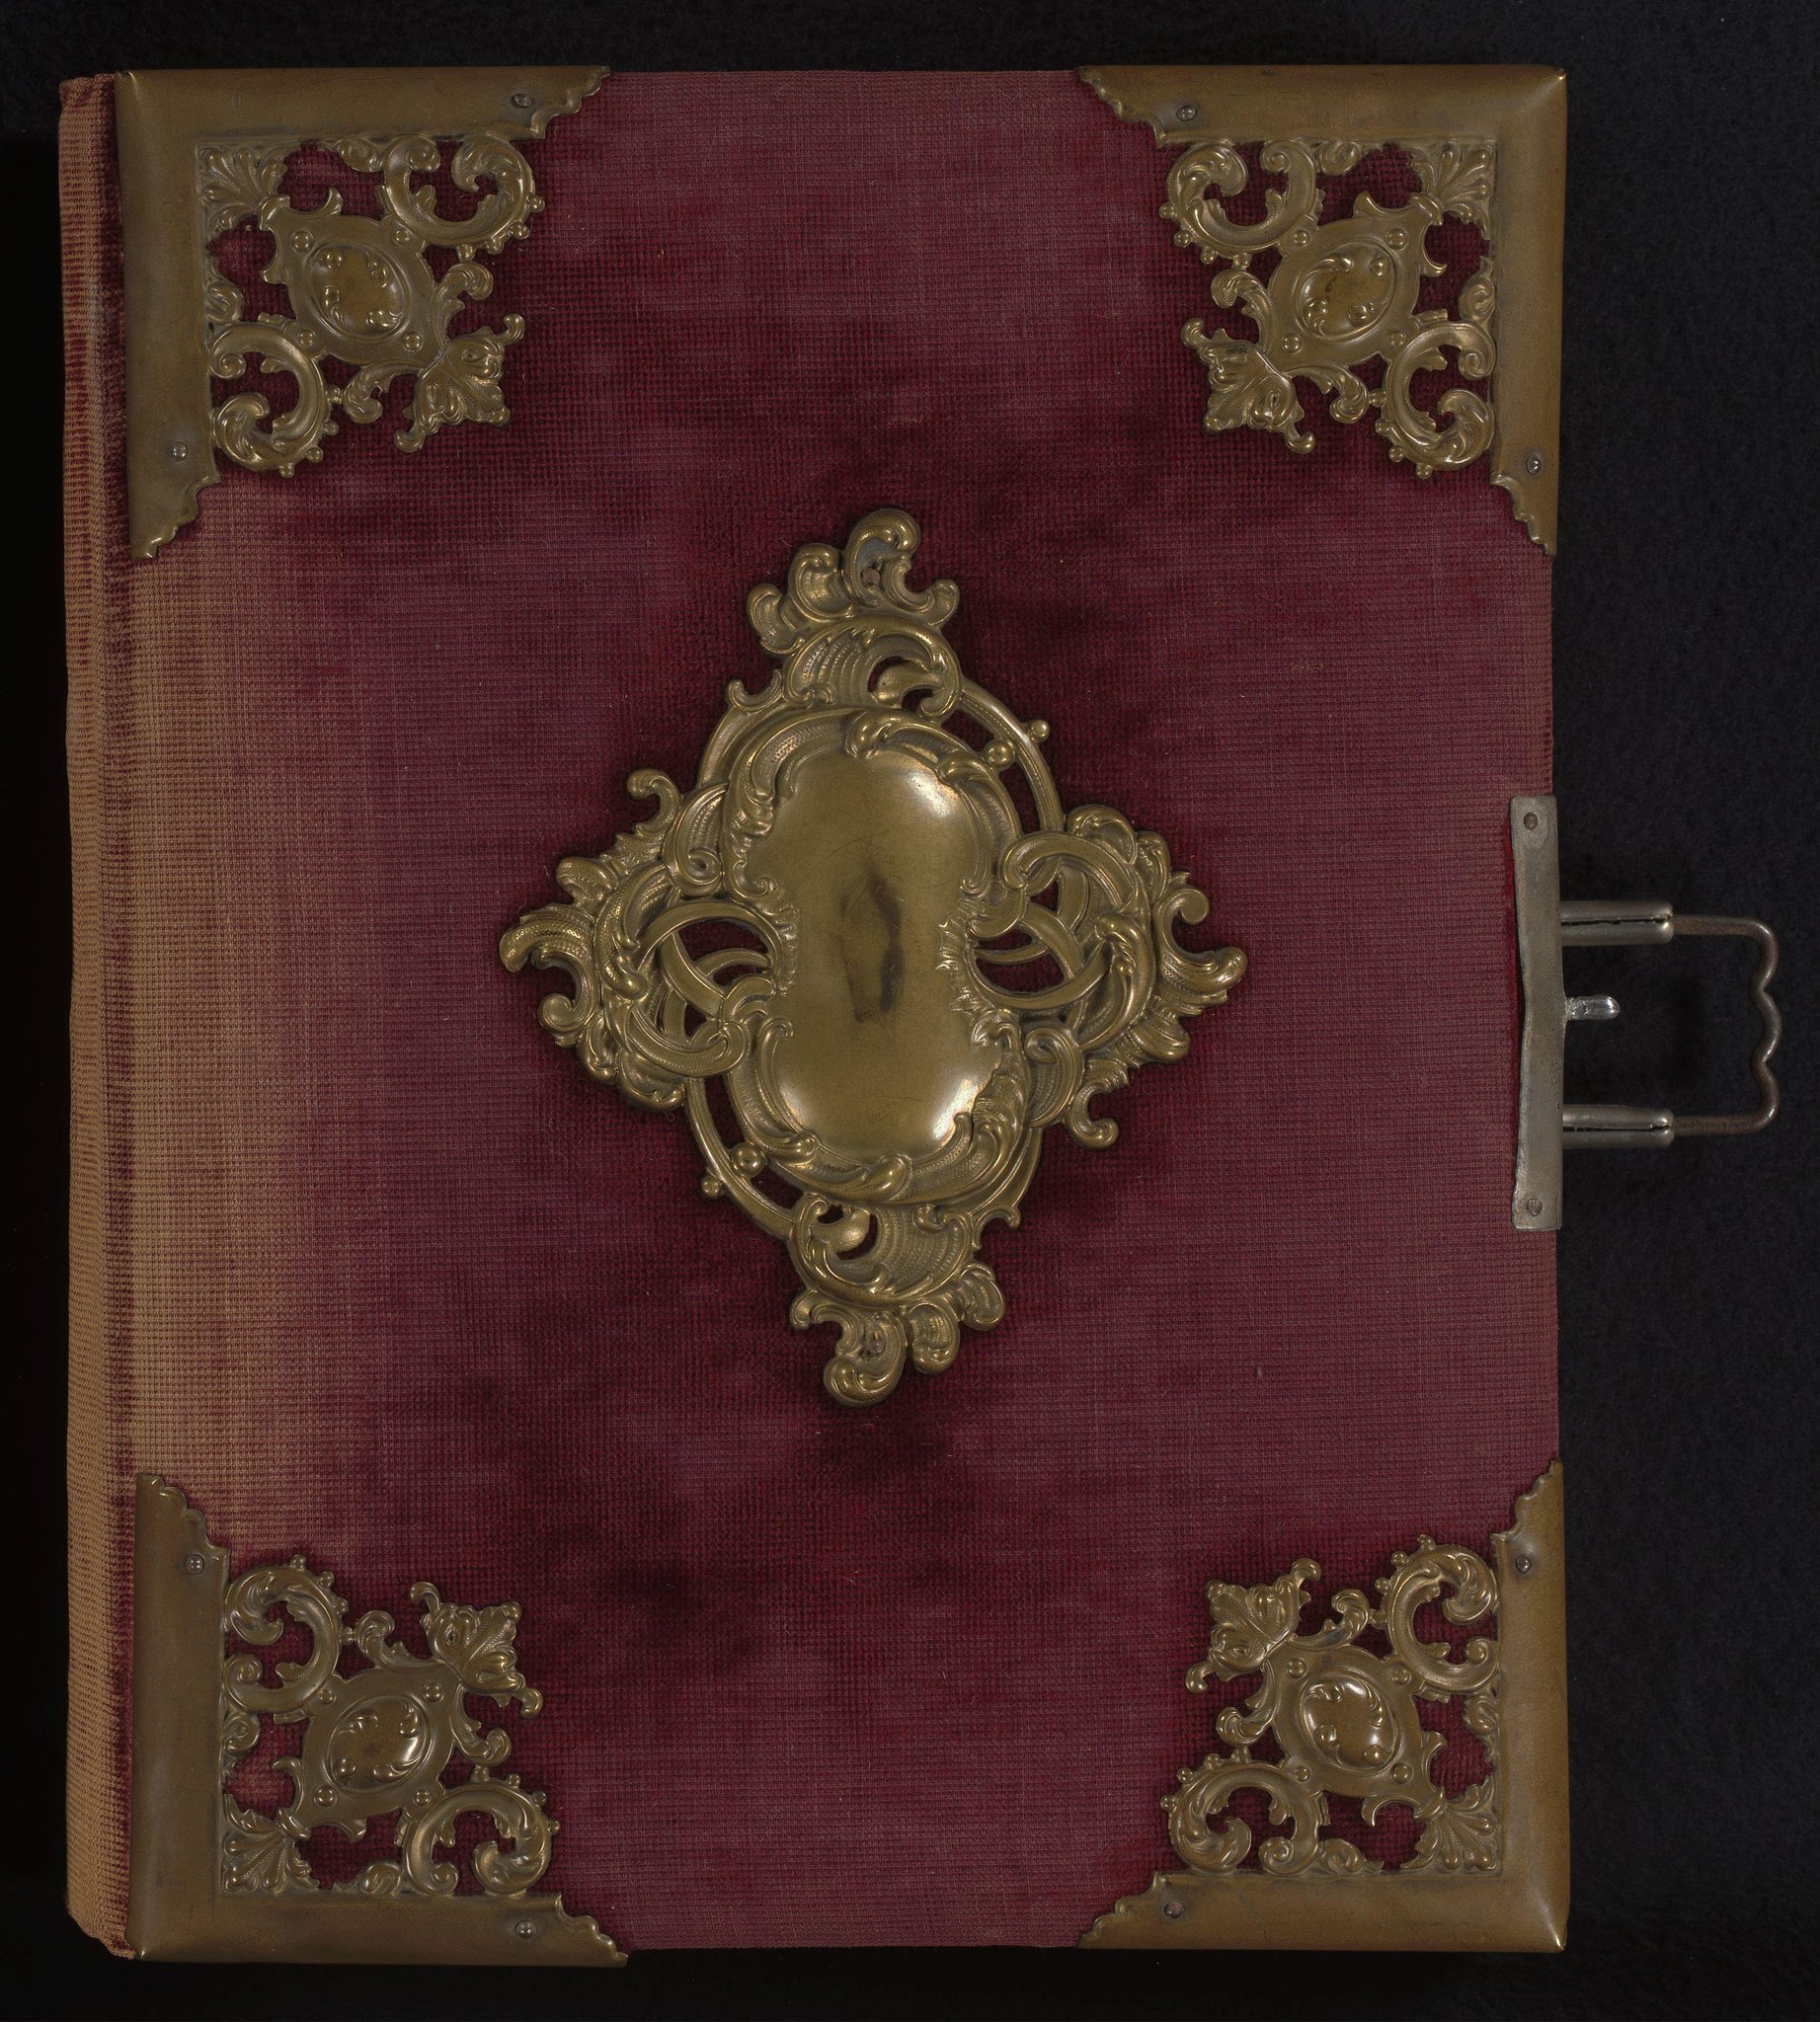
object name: slip in album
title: Fotoalbum met 56 foto's, Nederlands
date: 1860-1920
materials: cardboard, metal, paper, photographic support, textile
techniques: albumen print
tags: adolescent, young woman, maiden, historical persons - bb - woman, boy (child between toddler and youth), child, historical persons, youth, adolescent, girl (child between toddler and youth), head-gear: cap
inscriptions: collector's mark: ‘Dienst Verspreide Rijkskollekties (...) A706’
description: Fotoalbum met 56 foto's op 28 pagina's met insteekpasse-partouts. Het album bevat naast een foto van een standbeeld van een geestelijke alleen maar portretten. De foto's zijn van diverse vervaardigers, onder andere Albert Greiner, Bernardus Bruining en Herman van der Worp, enkele foto's zijn anoniem.